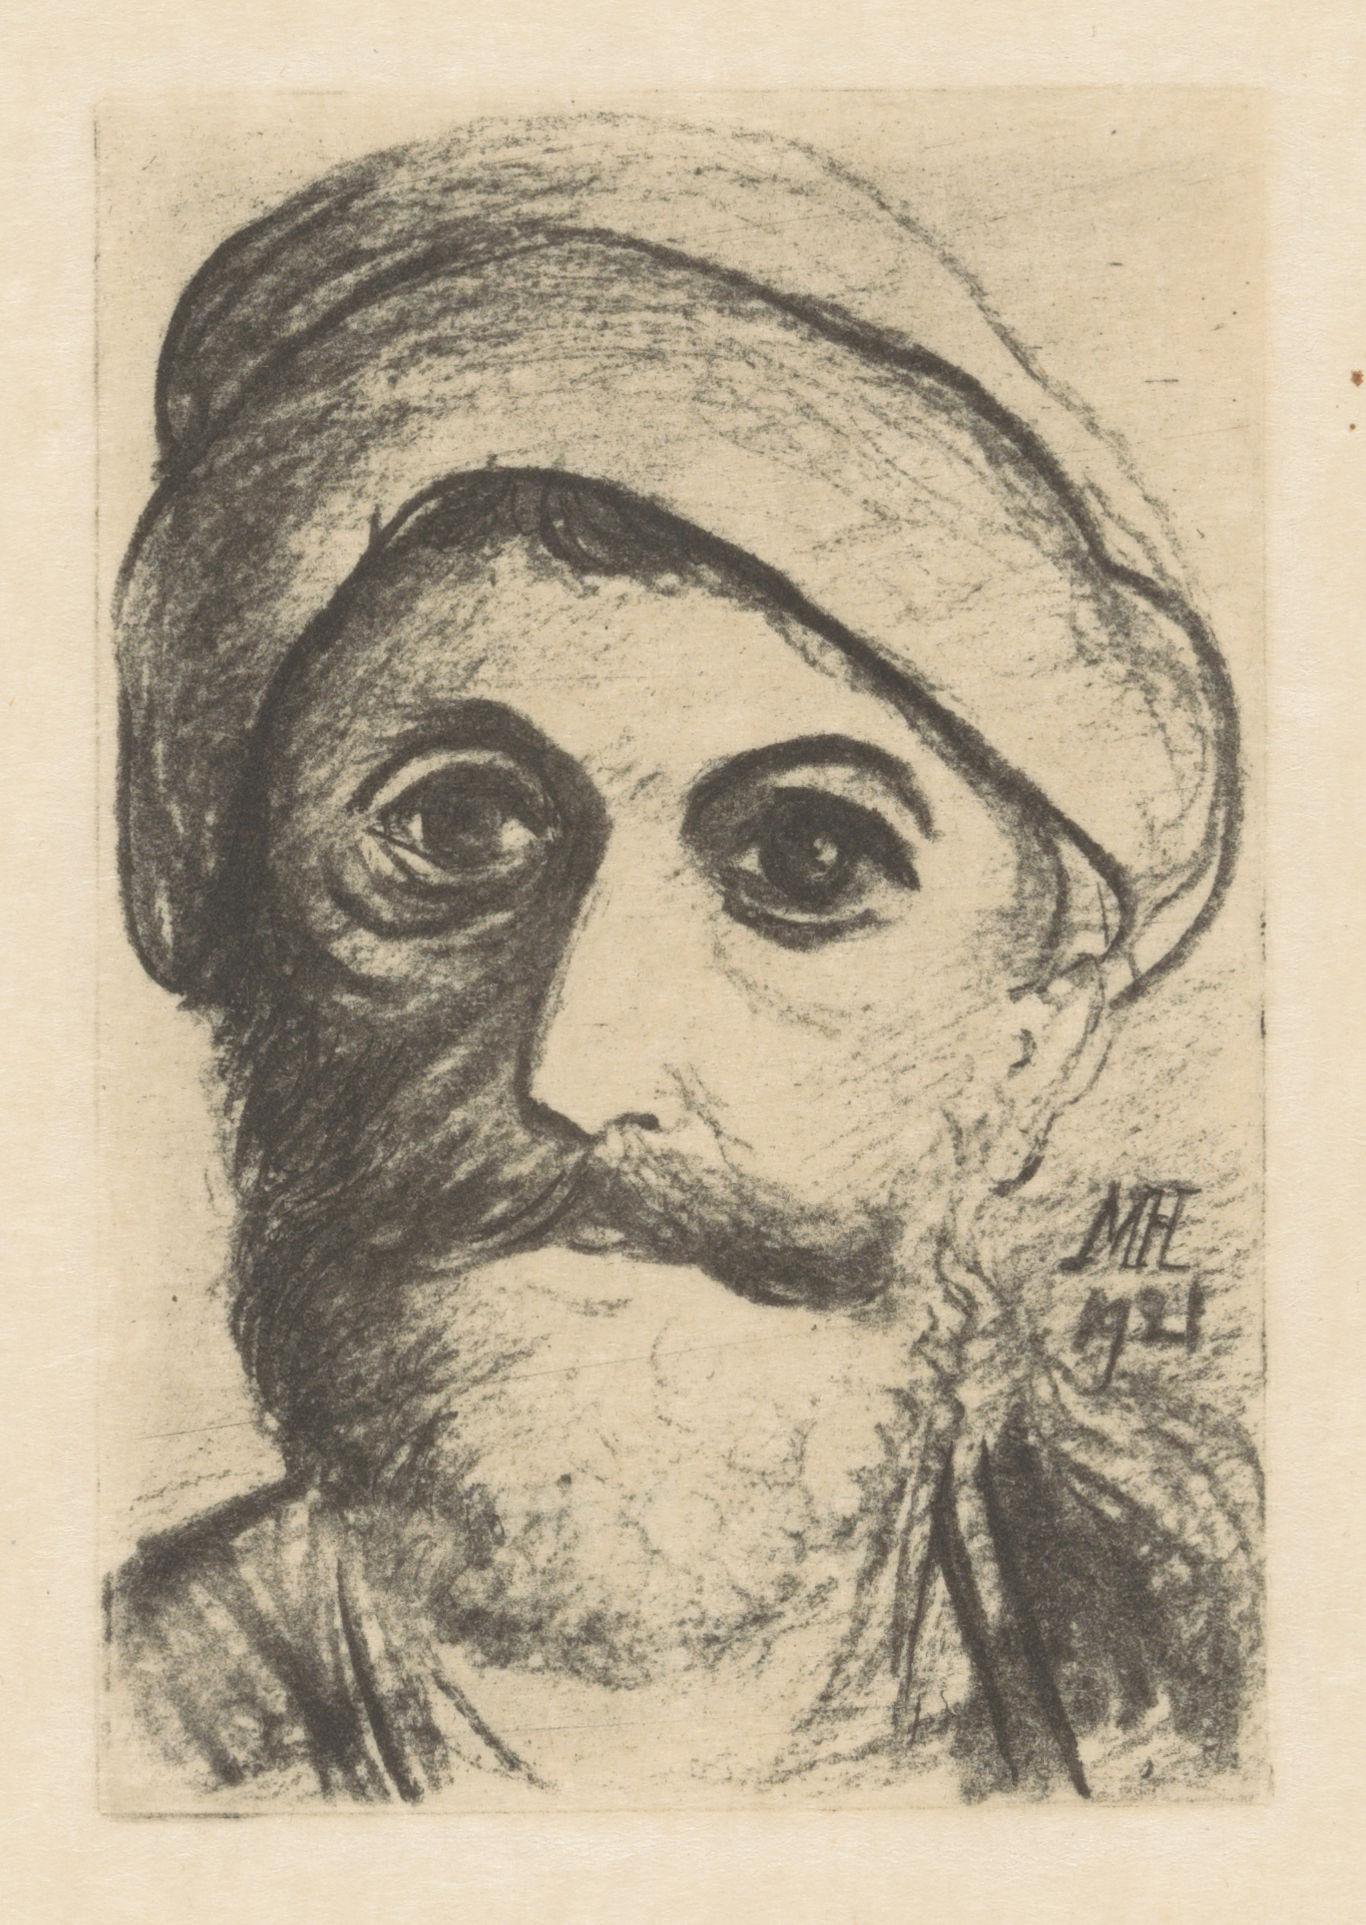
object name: print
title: Man met baard en muts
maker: marius holleman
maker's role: draughtsman, print maker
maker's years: 1878-1926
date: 1921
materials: paper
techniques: etching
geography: groningen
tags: head-gear: hat, beard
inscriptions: collector's mark: Lugt 2228